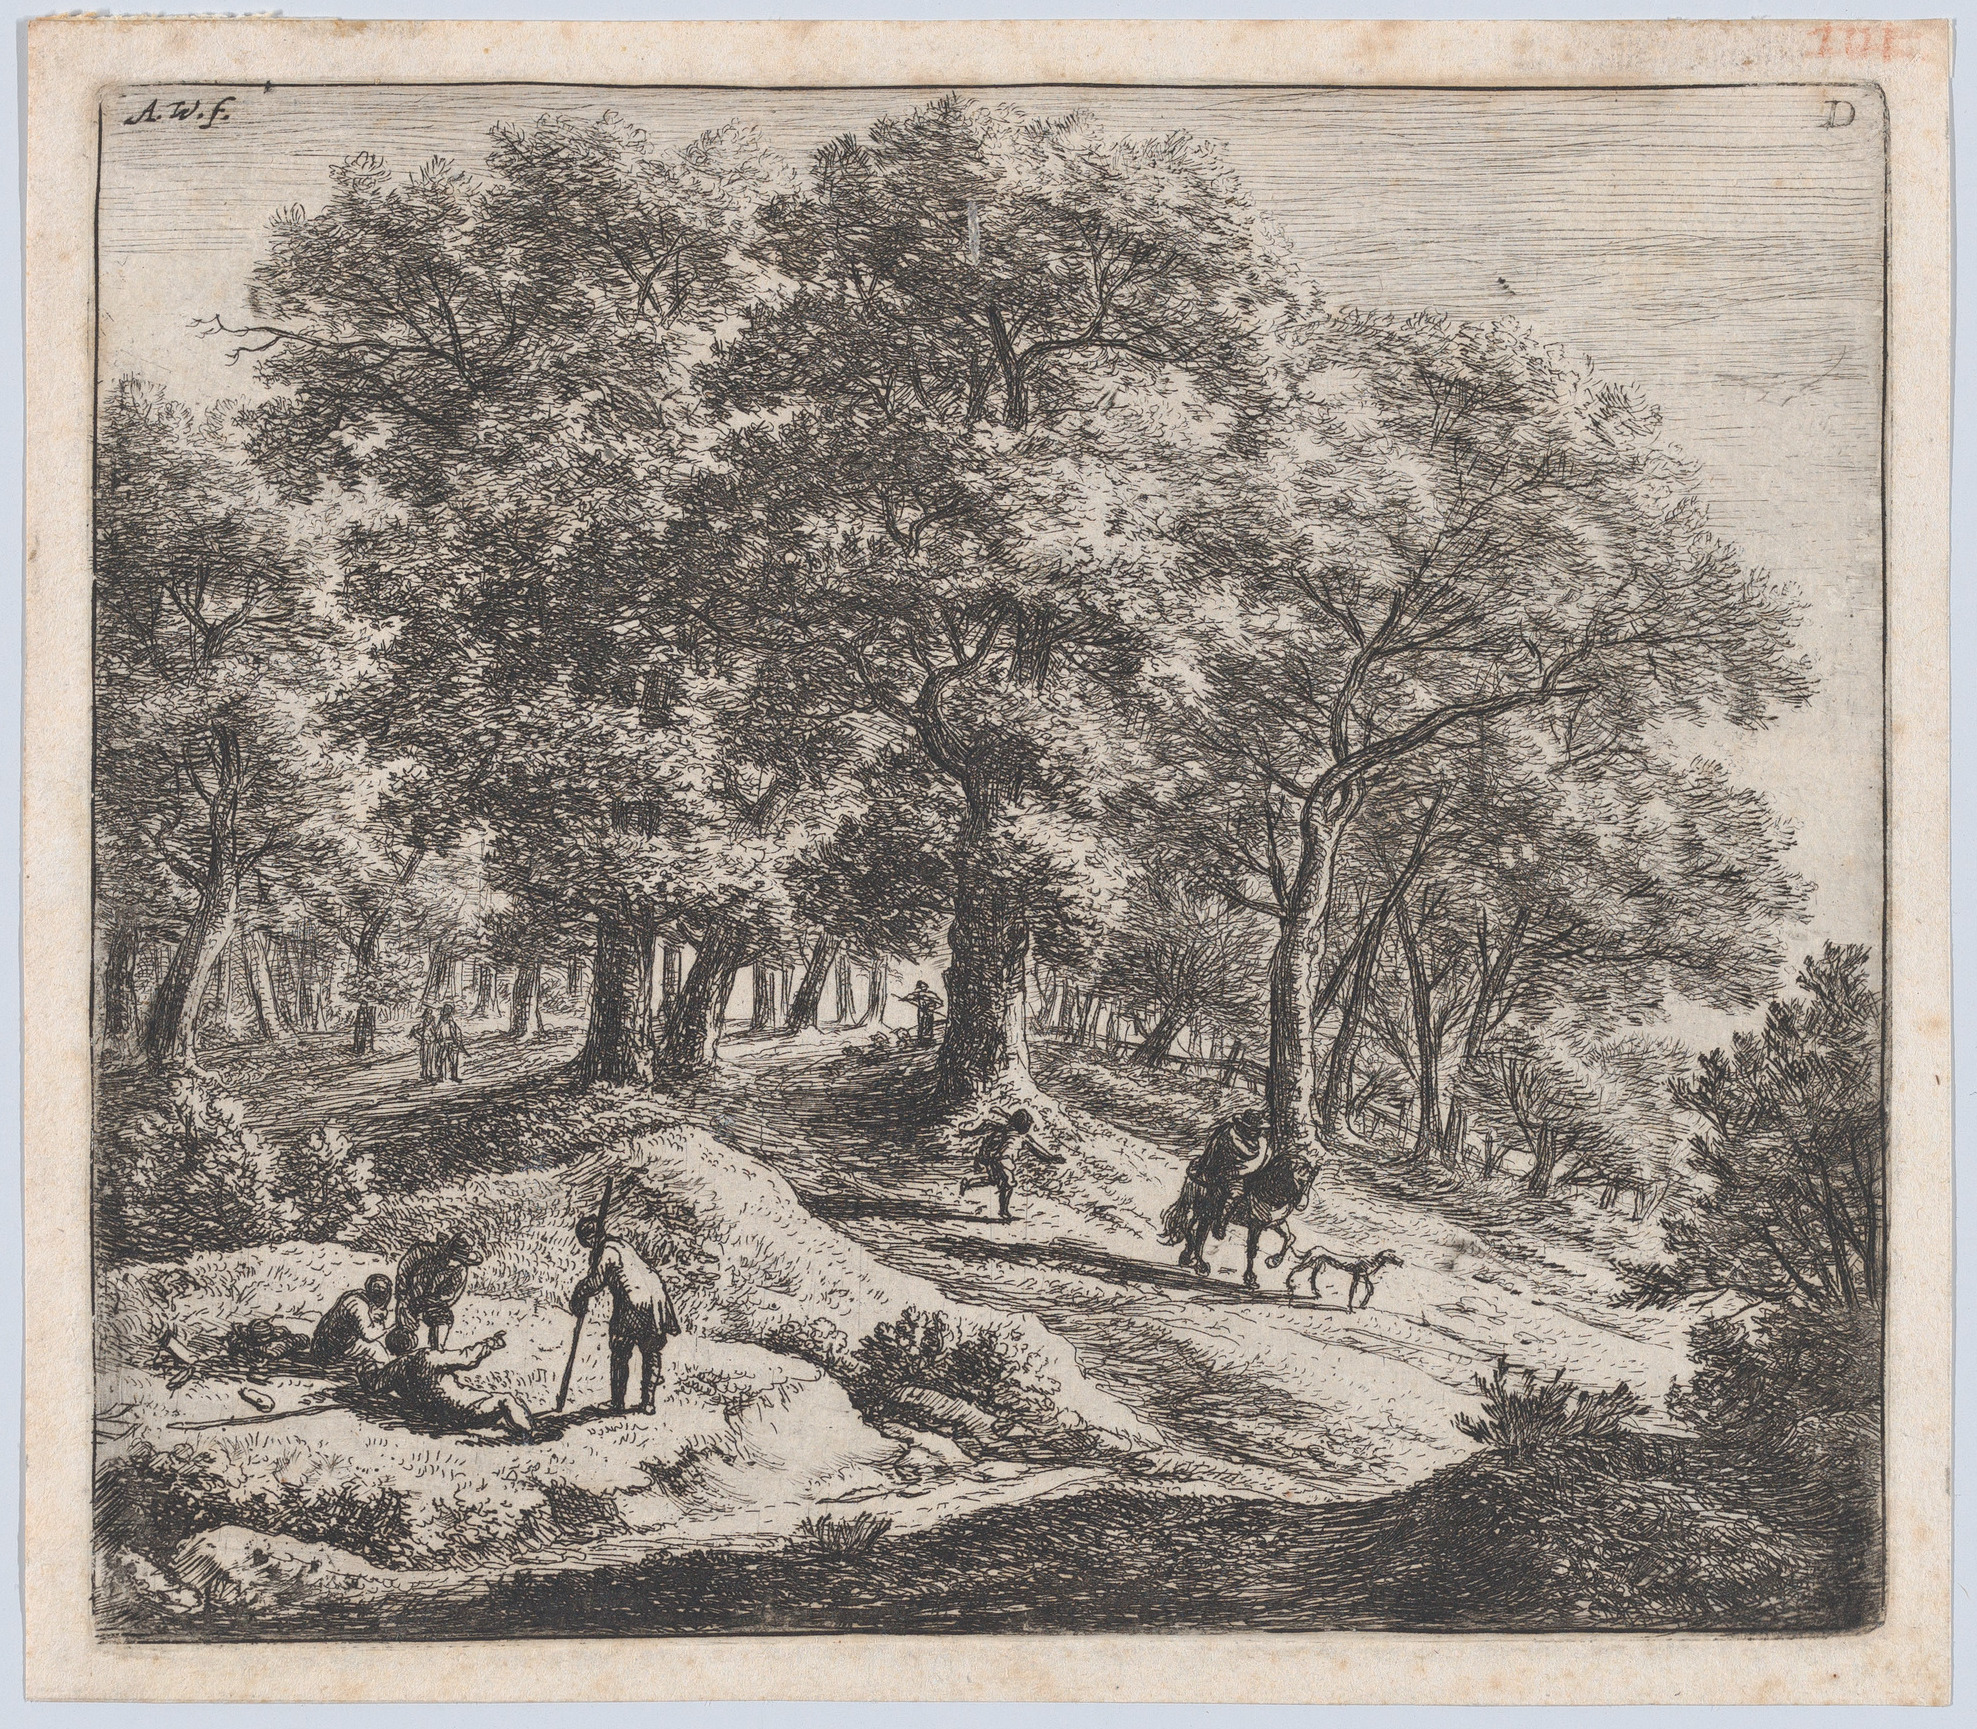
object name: print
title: The Hunters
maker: anthonie waterloo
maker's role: artist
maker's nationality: dutch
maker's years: 1609-1690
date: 1601-1700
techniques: etching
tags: human figures,animals,trees